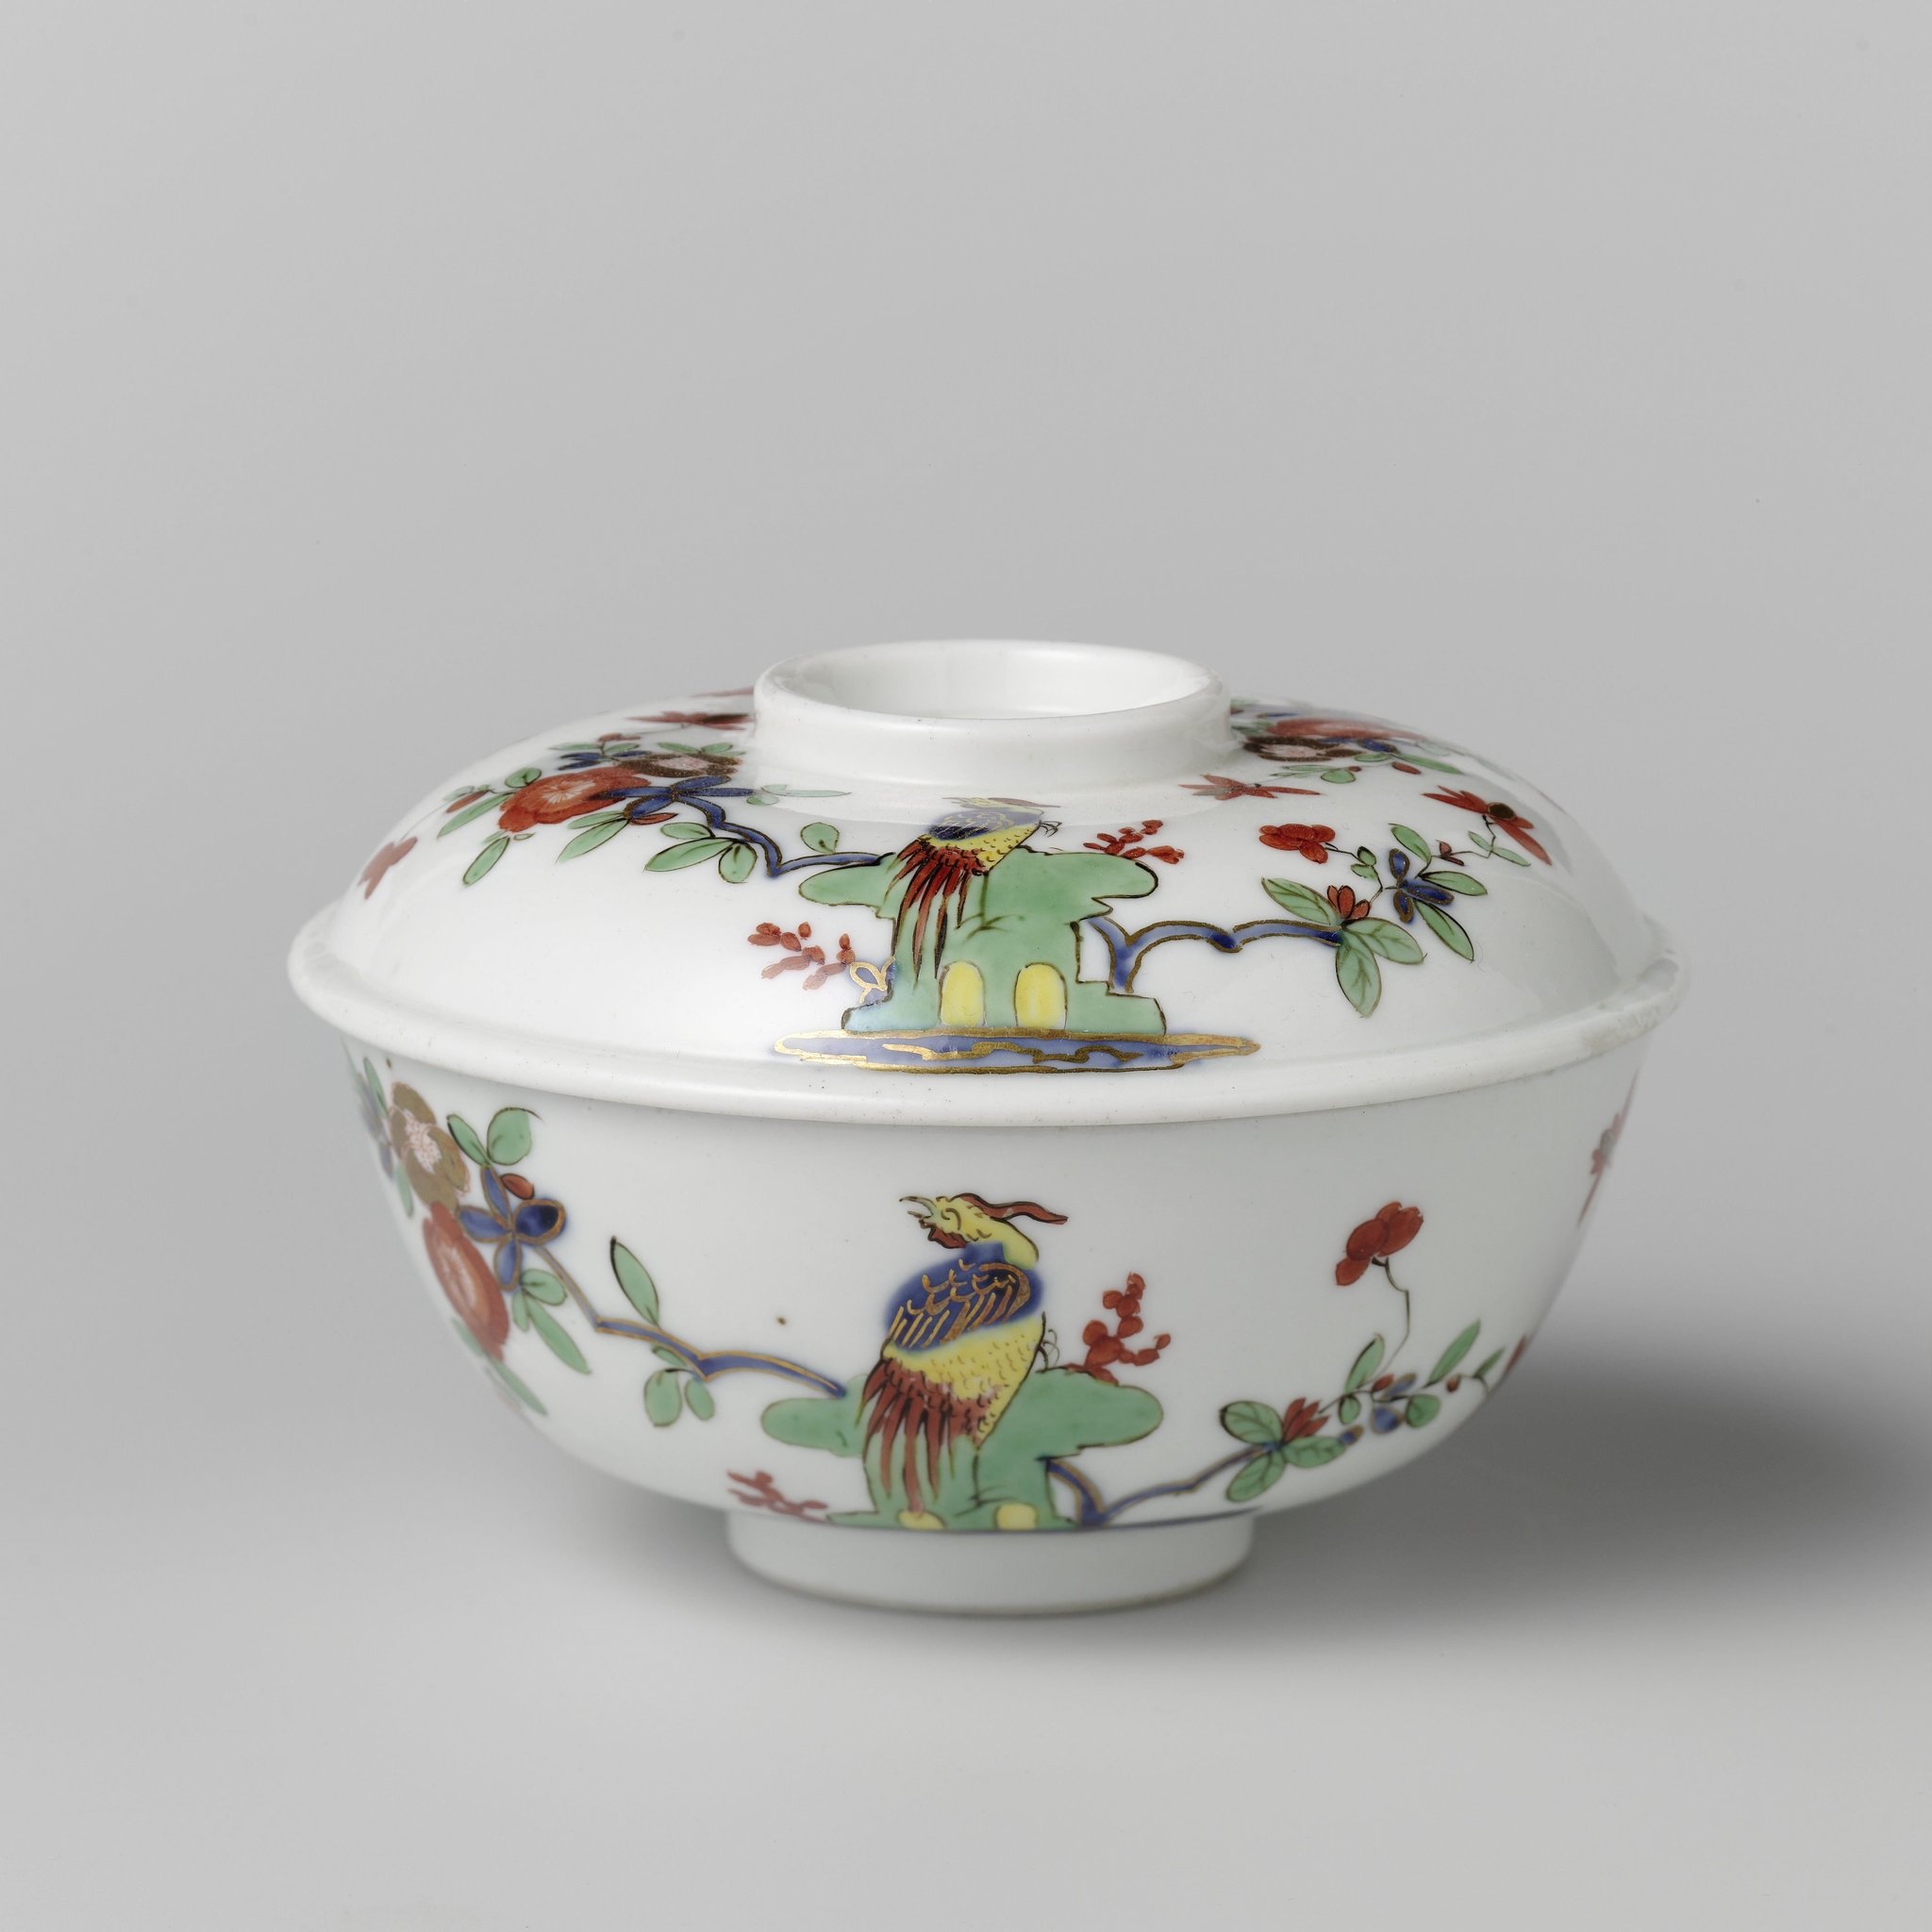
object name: eating drinking utensil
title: Kom, veelkleurig beschilderd met een Kakiemon-decor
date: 1725-1730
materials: porcelain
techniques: painted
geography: meissen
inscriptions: factory mark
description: Kom, van beschilderd porselein. De kom heeft een gewelfd deksel met in het midden een opstaande ring. De beschildering bestaat uit een vogel op een rots, waarachter aan weerszijden een tak met bloemen groeit. Deze voorstelling komt twee maal zowel op de kom als op het deksel voor. De kom is gemerkt.